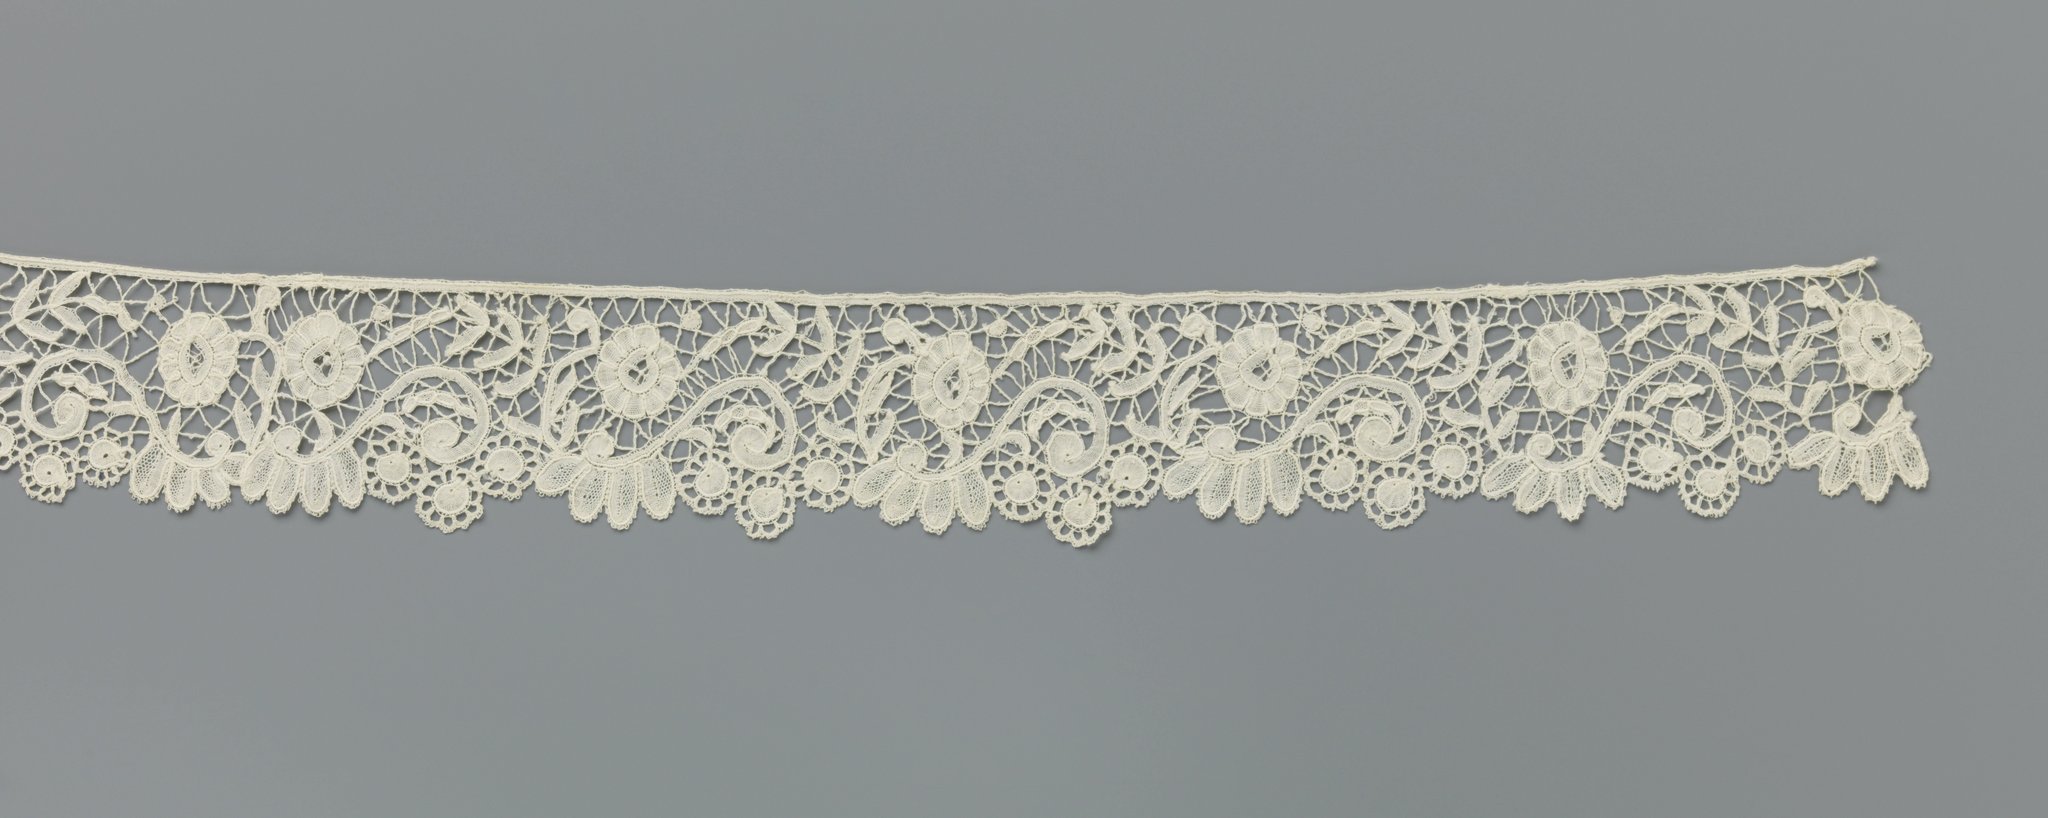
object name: strip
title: Strook kloskant met s-ranken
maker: Anonymous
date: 1875-1899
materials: linen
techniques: lace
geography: netherlands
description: Strook naturelkleurige kloskant: duchesse-kant. Op een vlechtengrond staat een lopend patroon. S-ranken met een drietal madeliefjes en een randje van campanes vormen de schulpen en eindigen in een voluut met enkelvoudig roosje.